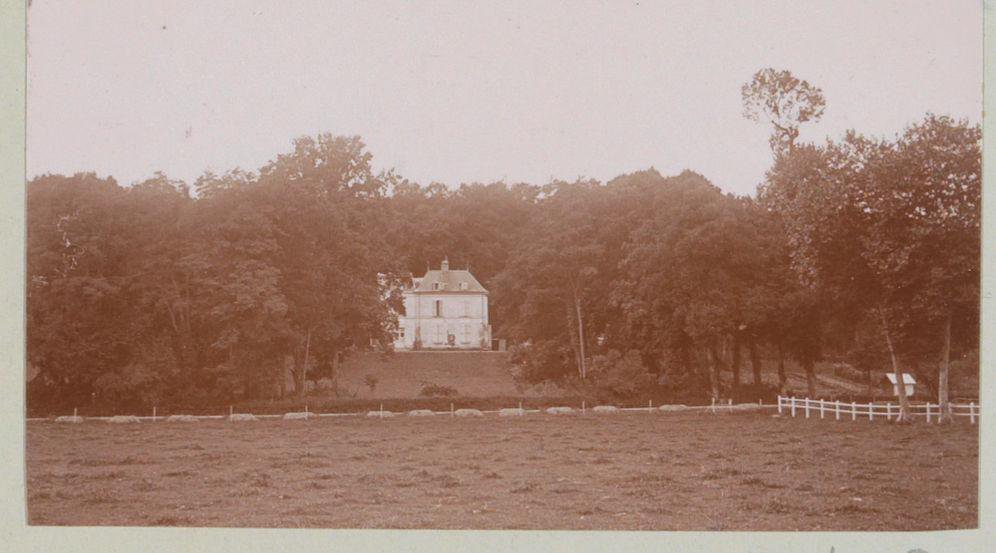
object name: photograph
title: Gezicht op een landhuis in bosrijke omgeving, vermoedelijk in Italië of Frankrijk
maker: Anonymous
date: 1905-1910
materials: paper, photographic support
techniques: gelatin silver print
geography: europe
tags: rural housing, e.g. country-house, villa, cottage, forest, wood, europe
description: Onderdeel van Fotoalbum van een Franse amateurfotograaf met bezienswaardigheden in Frankrijk, Zwitserland en Italië.